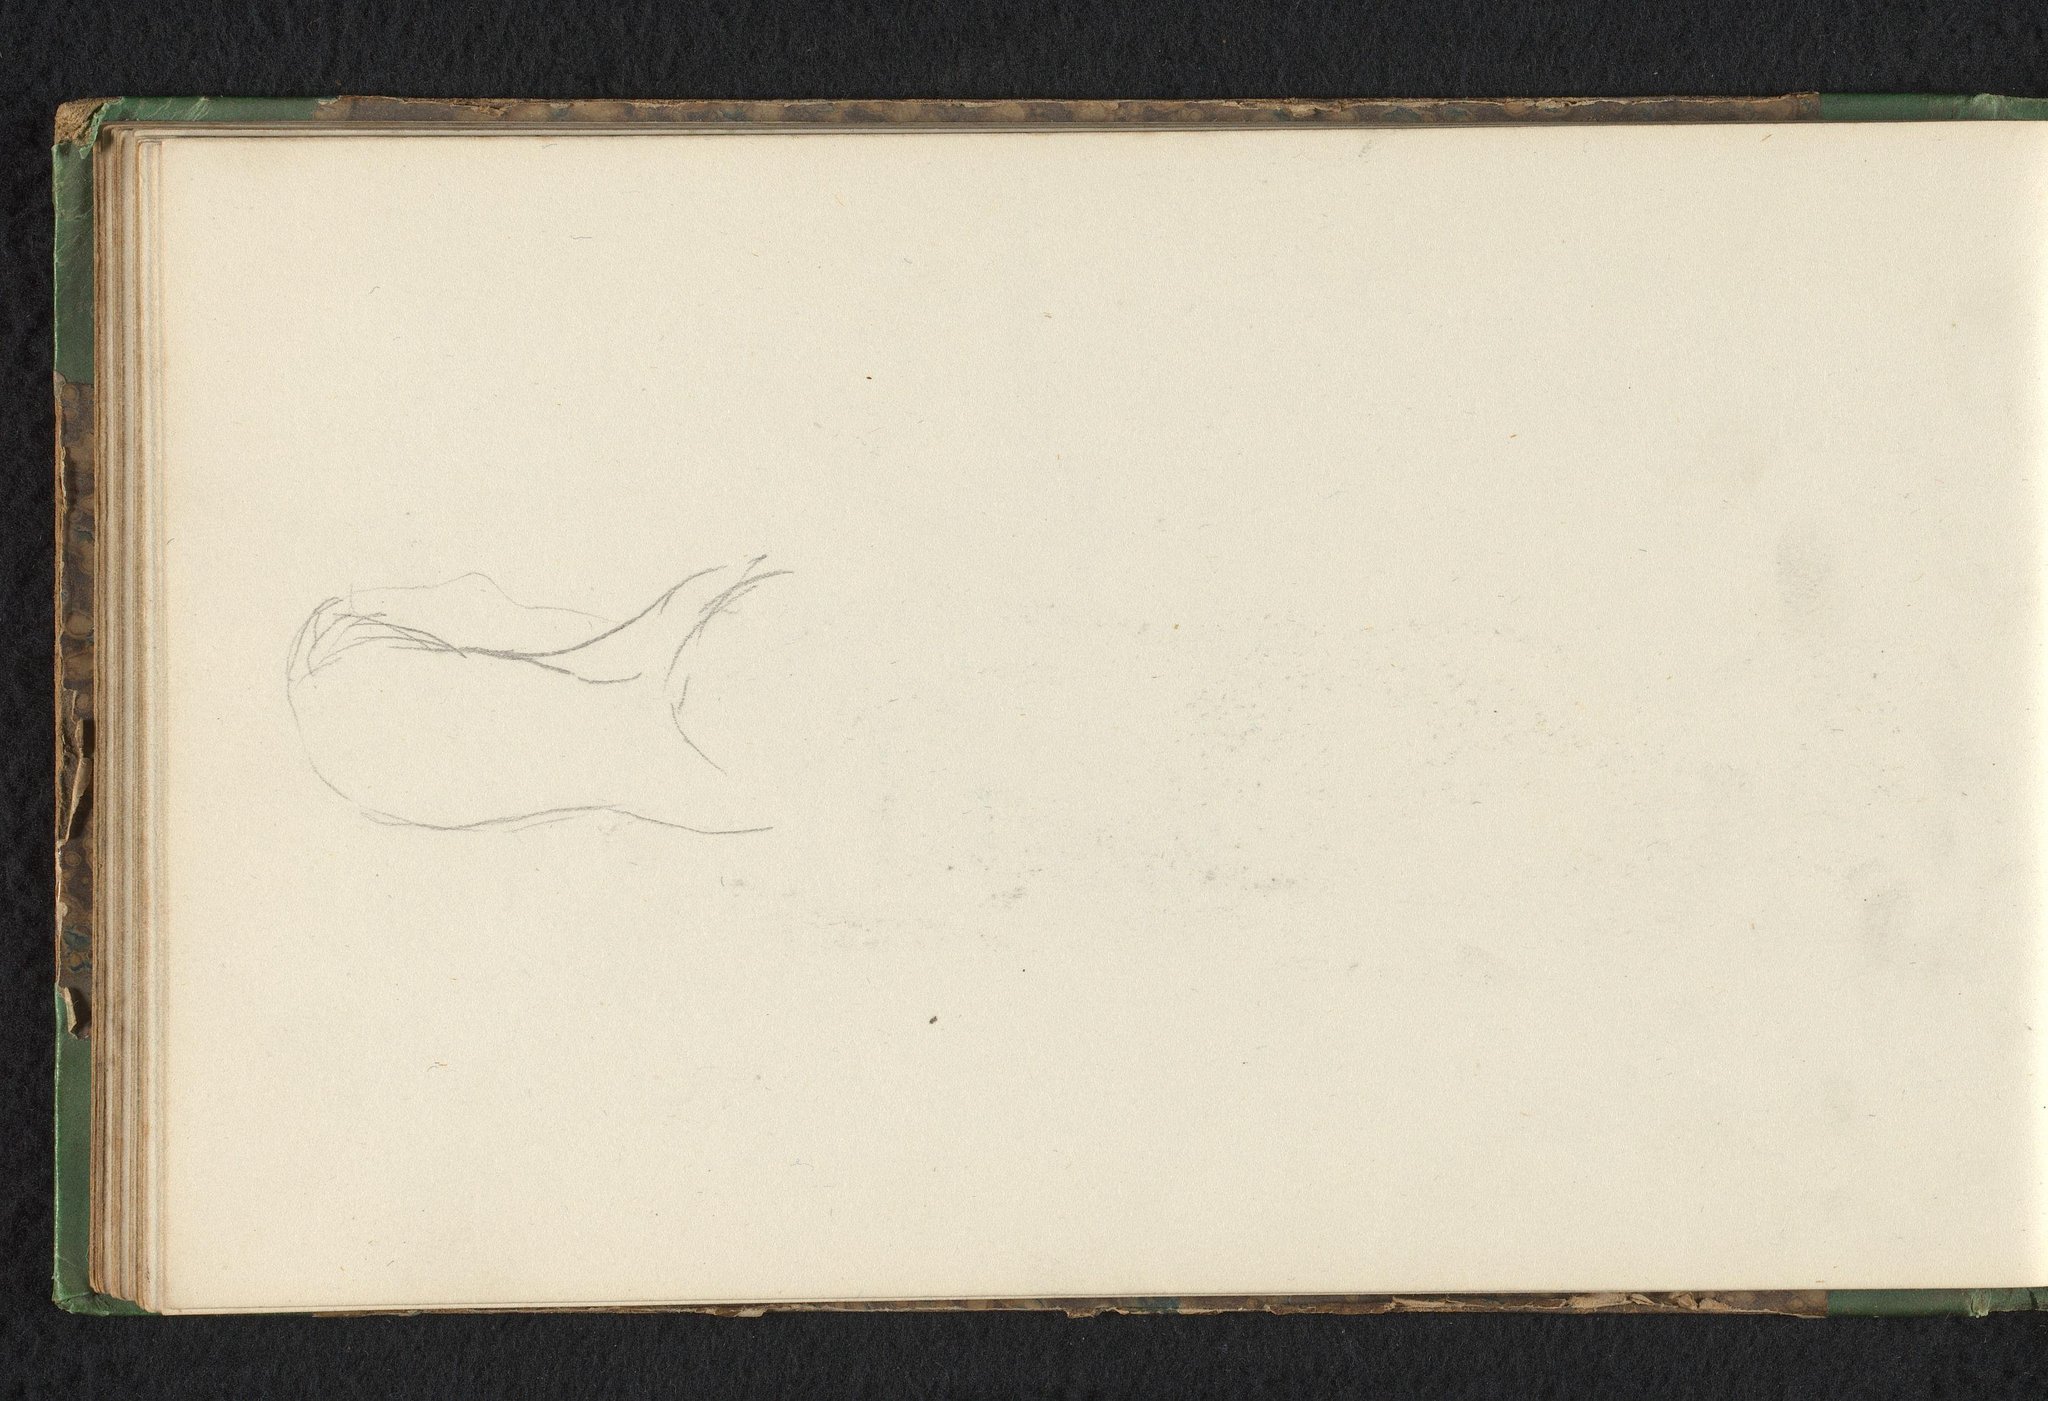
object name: sketchbook leaf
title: Portret van een onbekende vrouw en profil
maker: jan bedijs tom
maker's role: draughtsman, painter, print maker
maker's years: 1813-1894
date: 1823-1894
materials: paper, pencil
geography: the hague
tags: historical persons not known by name - bb - woman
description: Pagina 20 verso uit een schetsboek met 61 bladen.